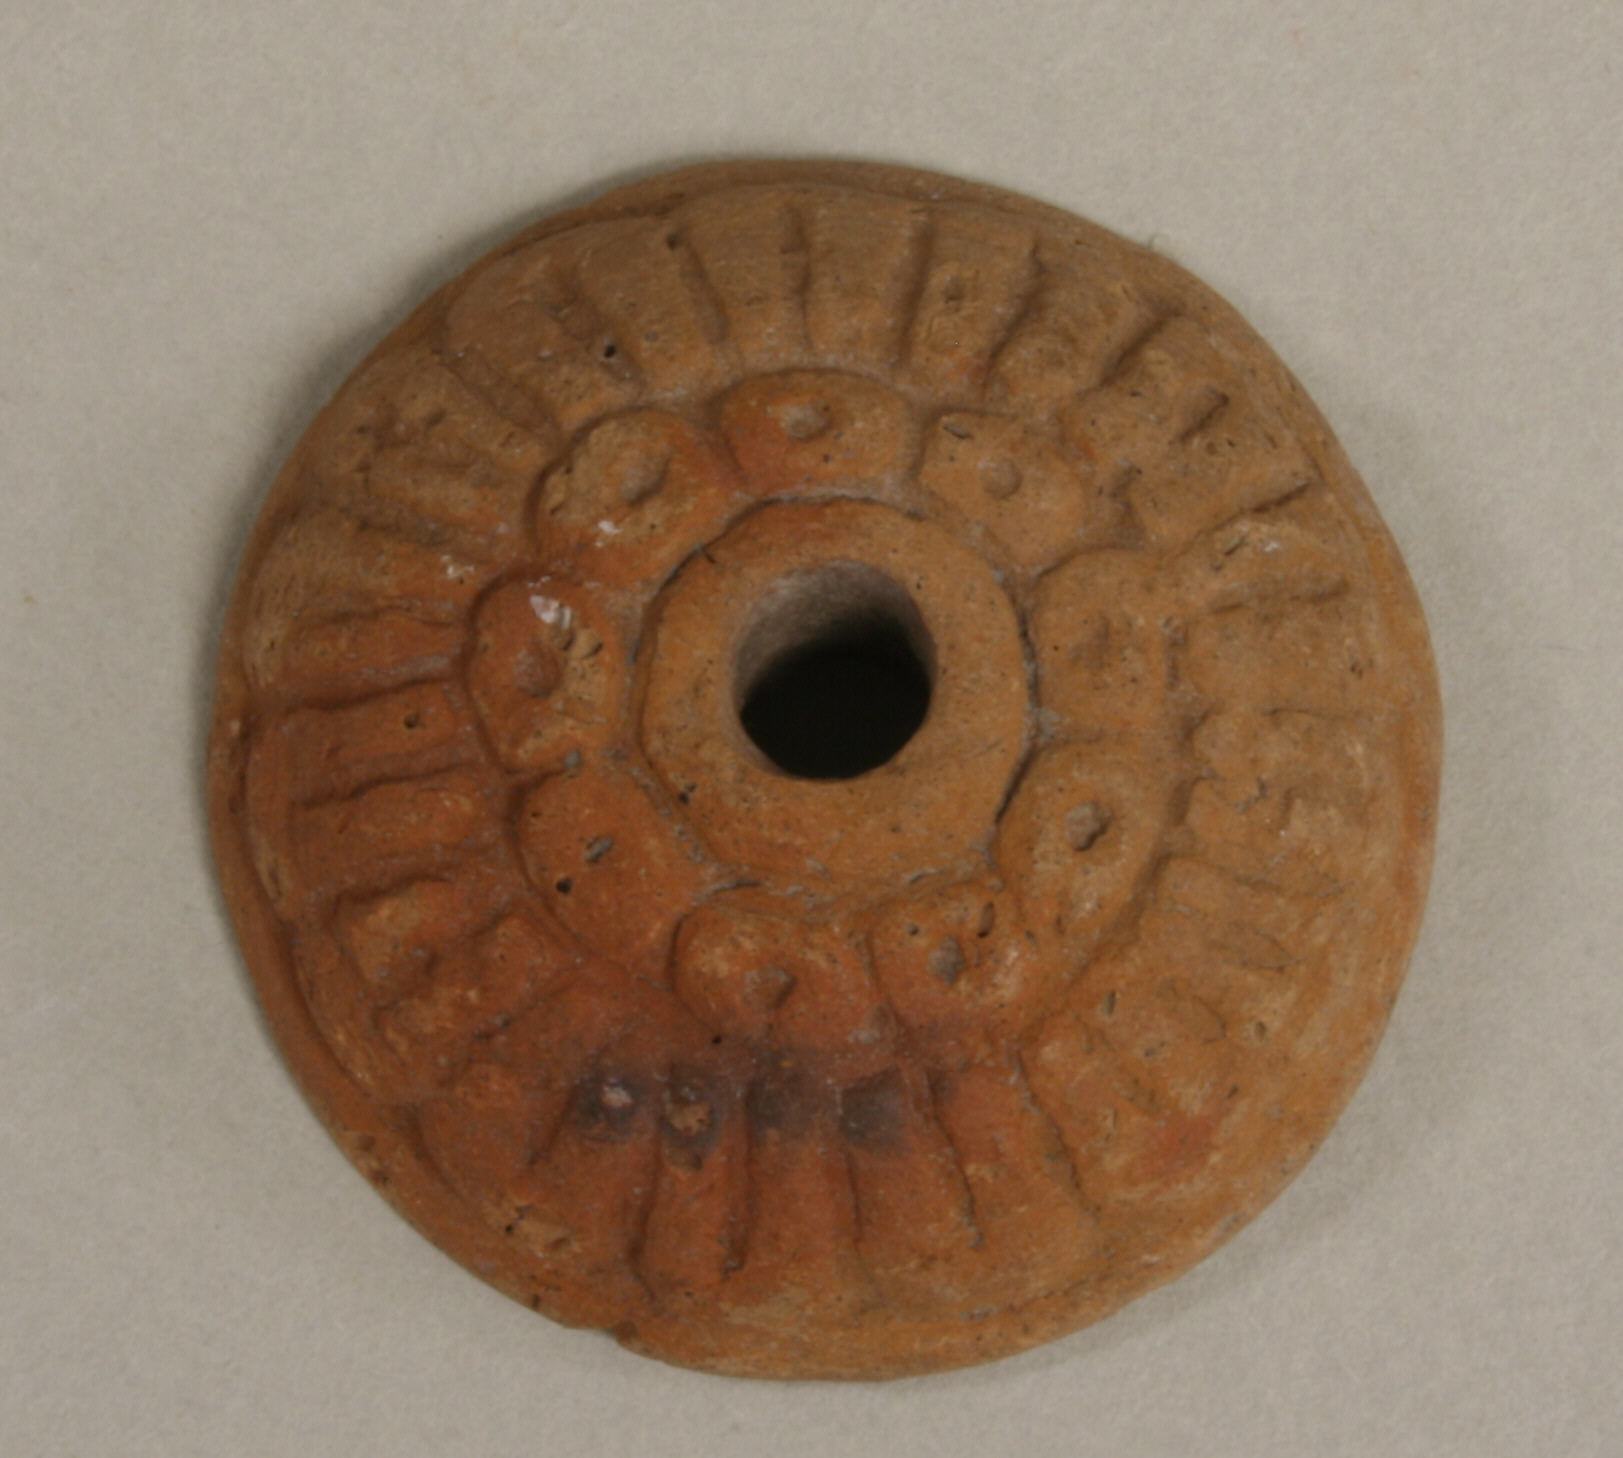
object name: spindle whorl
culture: mexican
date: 801-1500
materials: ceramic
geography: mexico